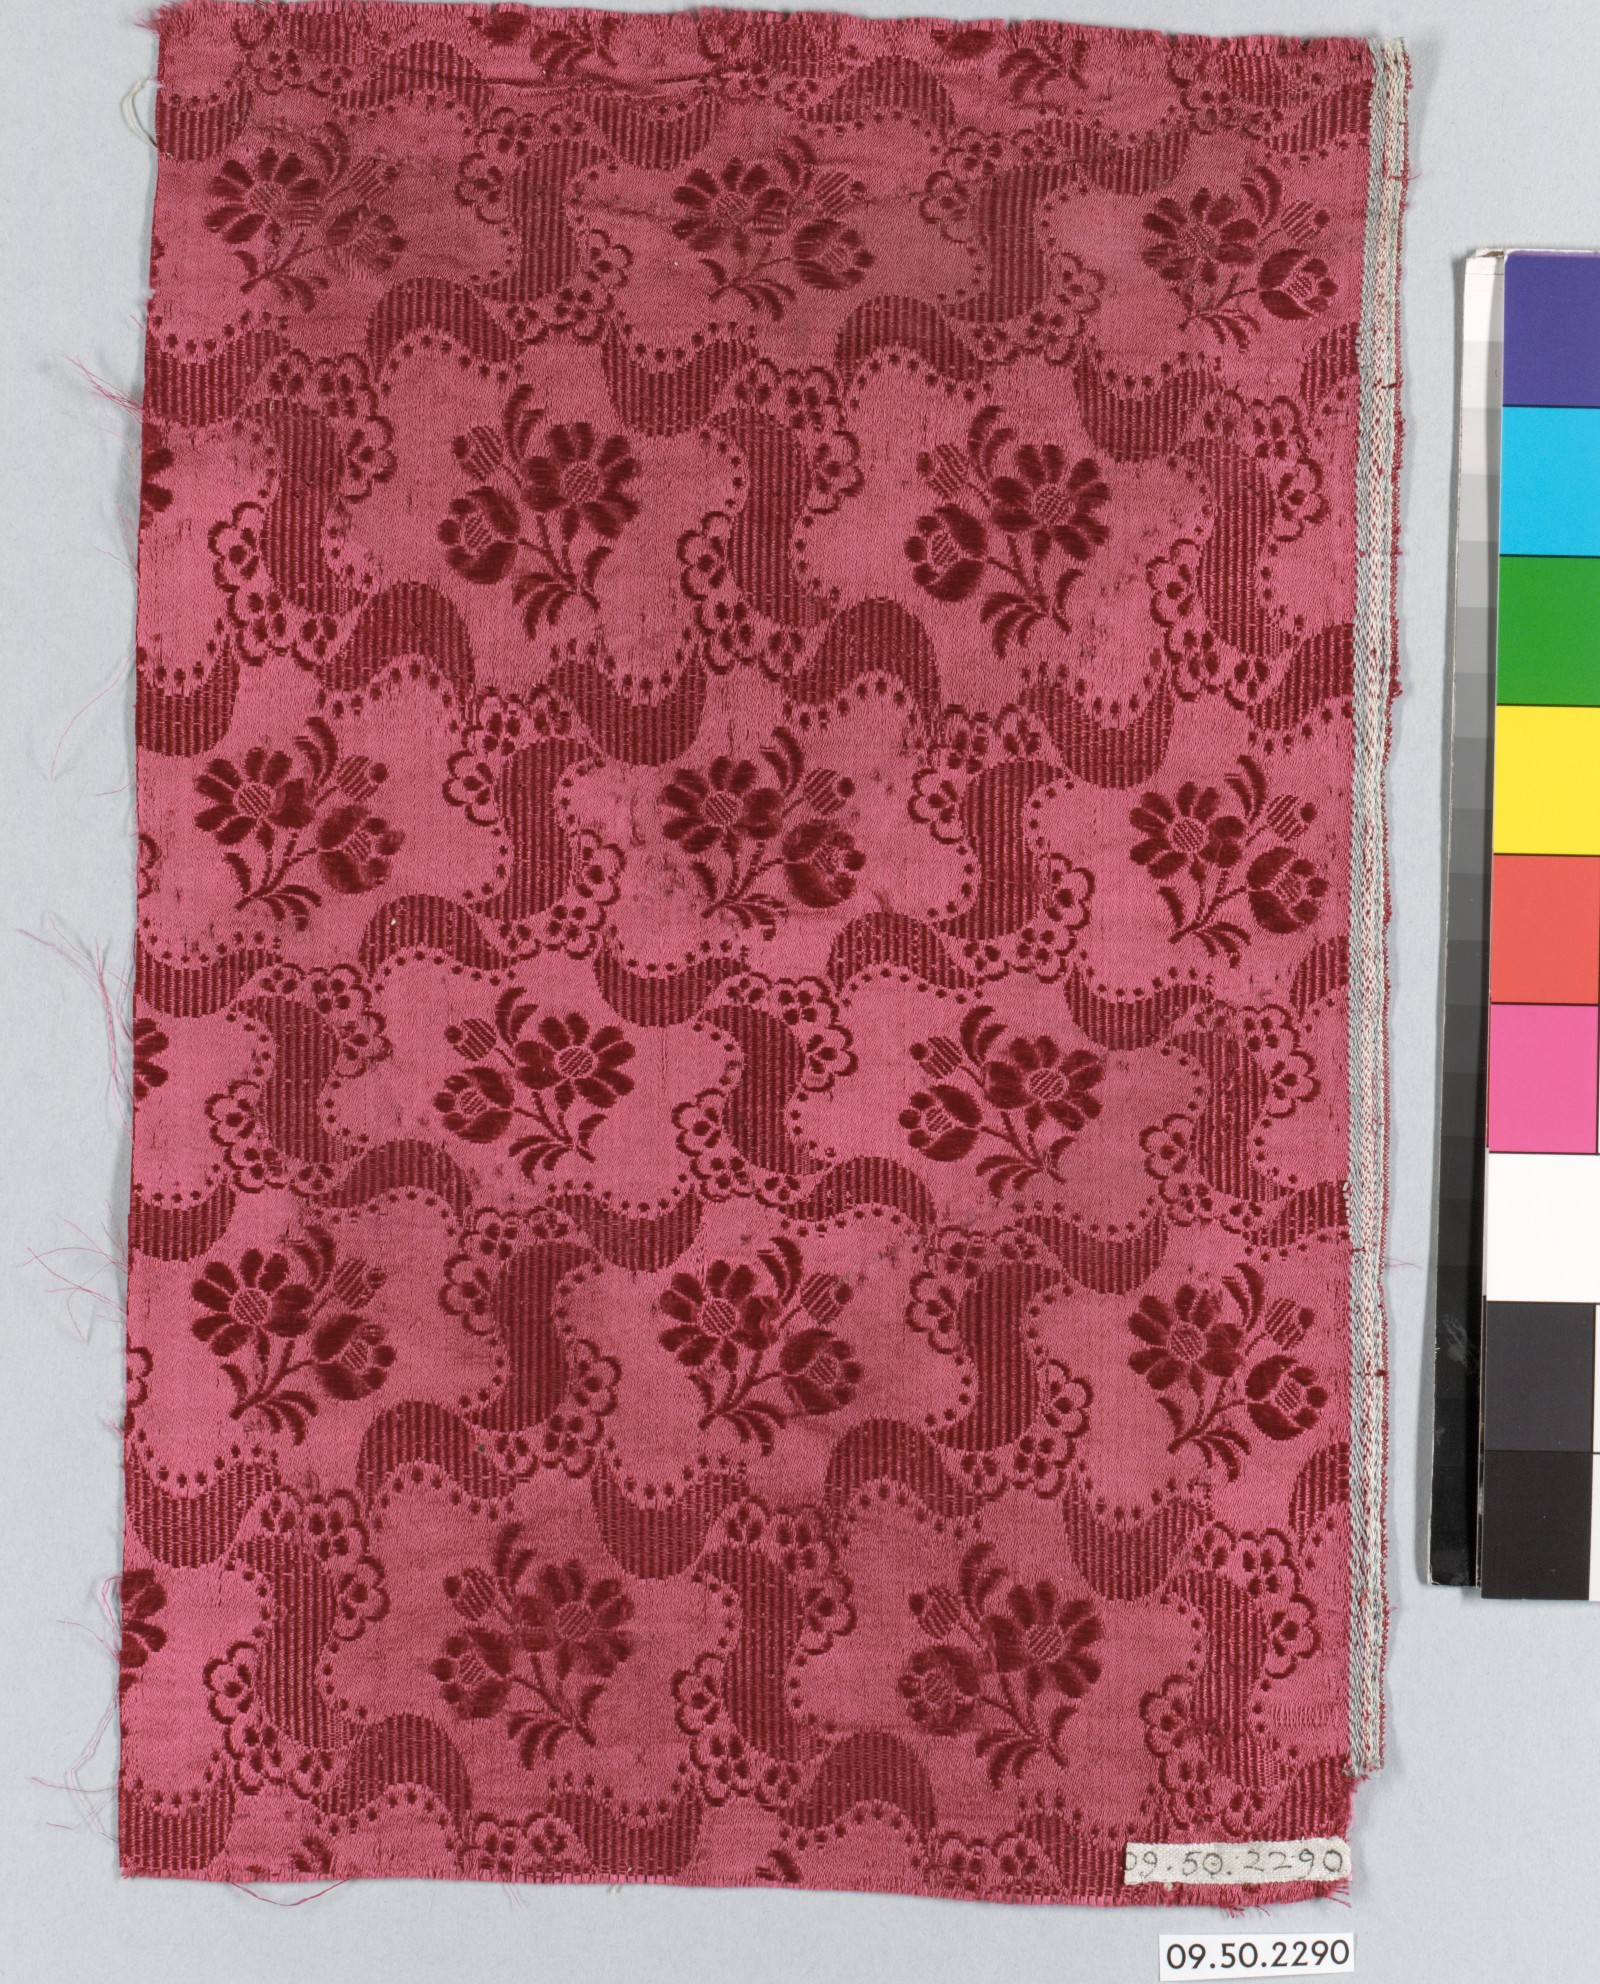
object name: piece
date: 1701-1800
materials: silk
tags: flowers,leaves